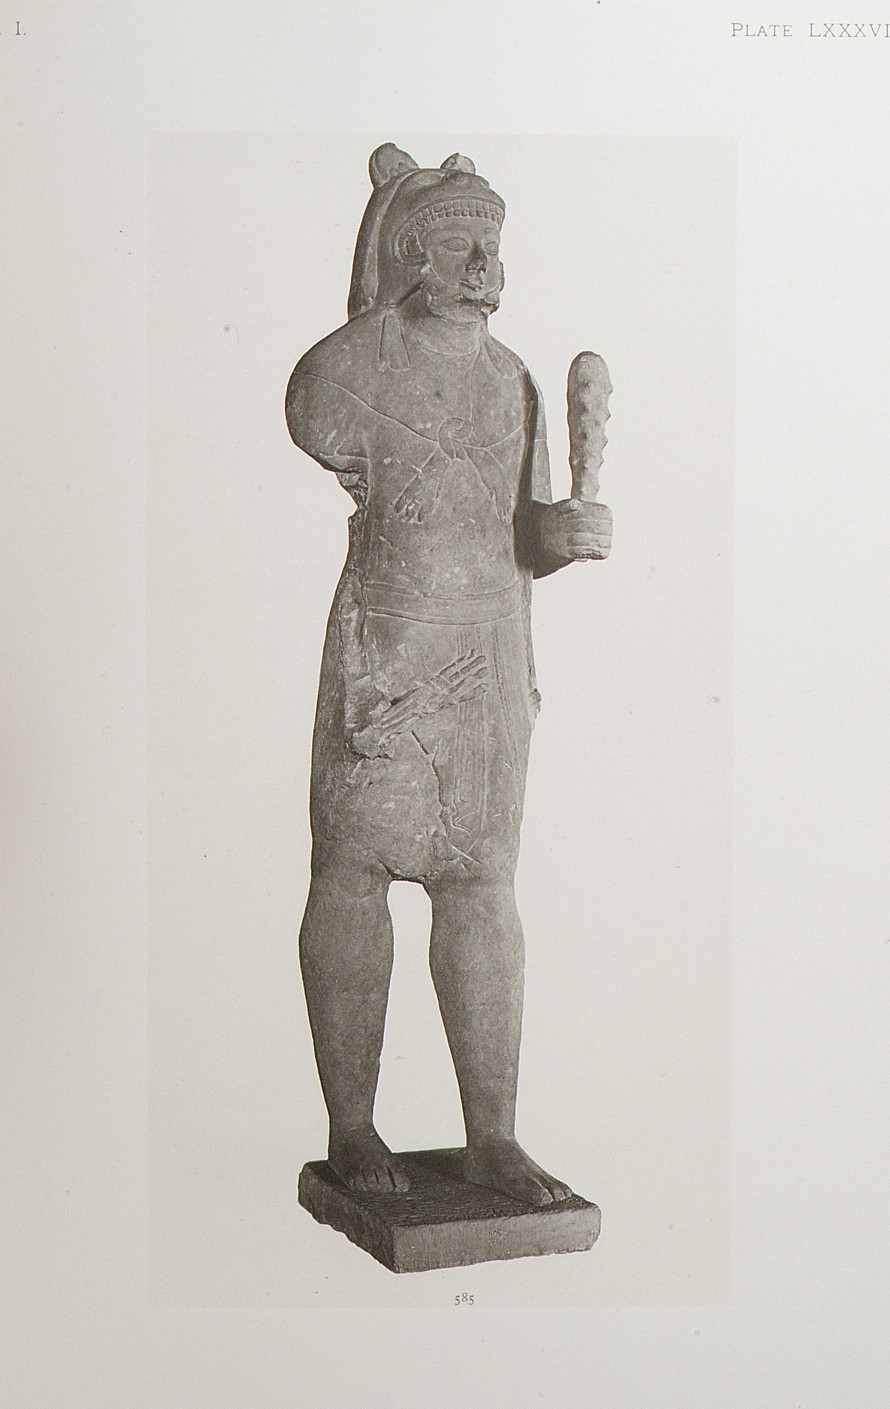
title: A Descriptive Atlas of the Cesnola Collection of Cypriote Antiquities in the Metropolitan Museum of Art, New York (1885–1903)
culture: american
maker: luigi palma di cesnola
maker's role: author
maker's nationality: american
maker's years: 1832-1904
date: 1885-1904